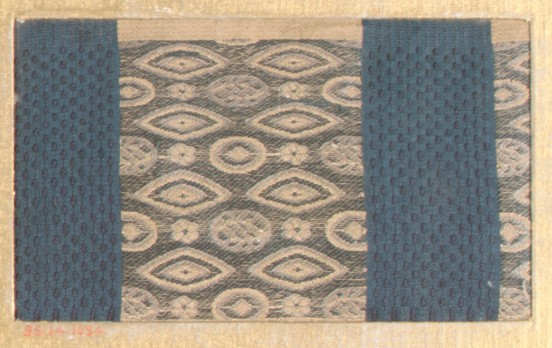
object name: piece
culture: japanese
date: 1701-1900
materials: silk